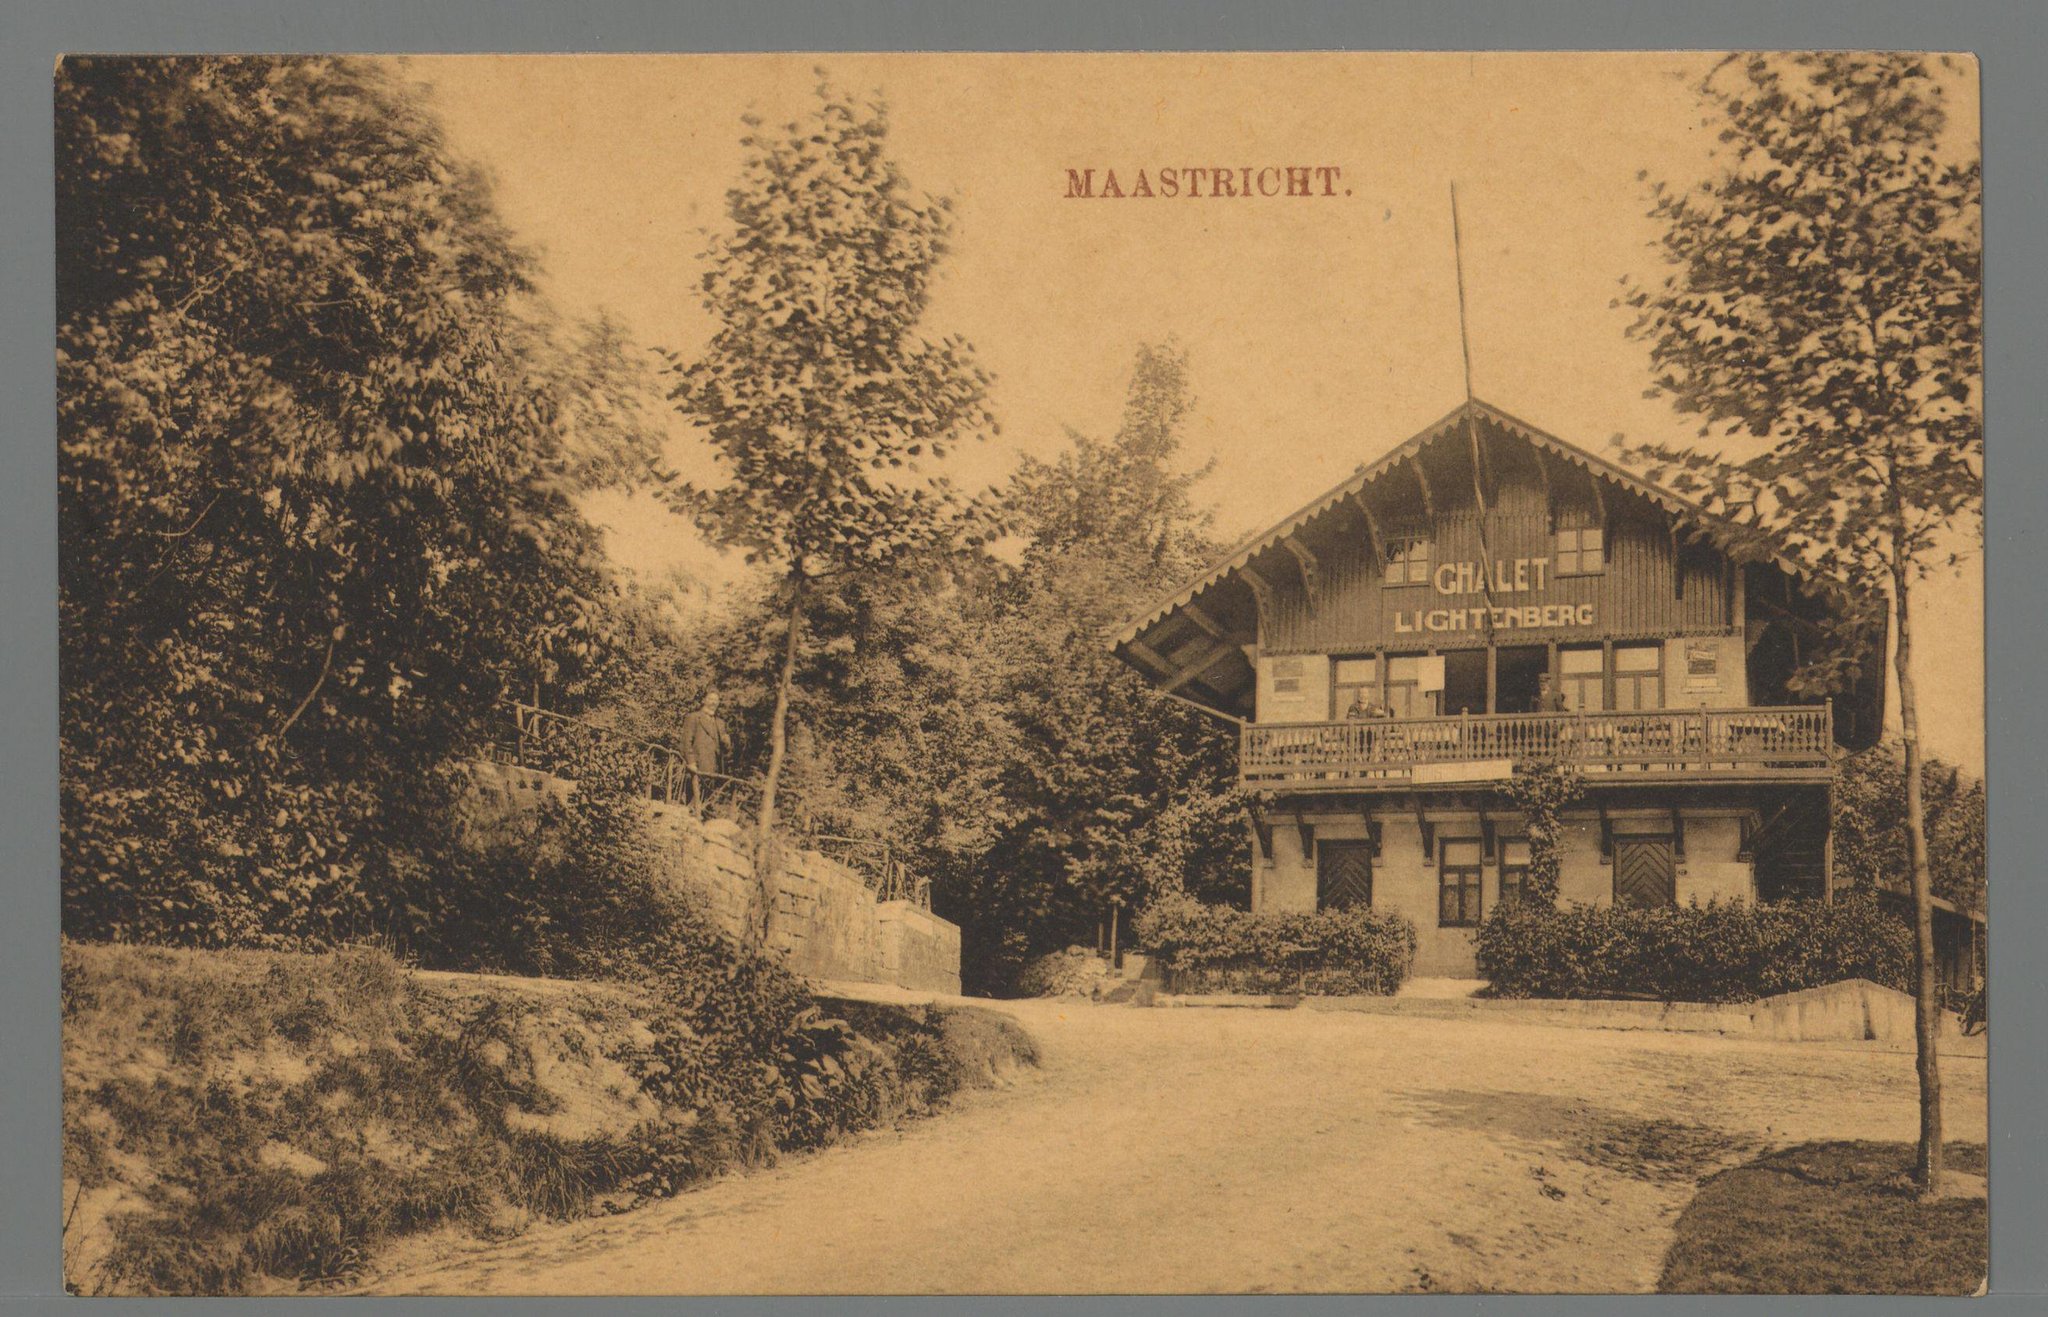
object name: ansichtkaart, prentbriefkaart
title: Maastricht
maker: Anonymous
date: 1905-1927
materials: cardboard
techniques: photograph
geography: maastricht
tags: cottage, maastricht